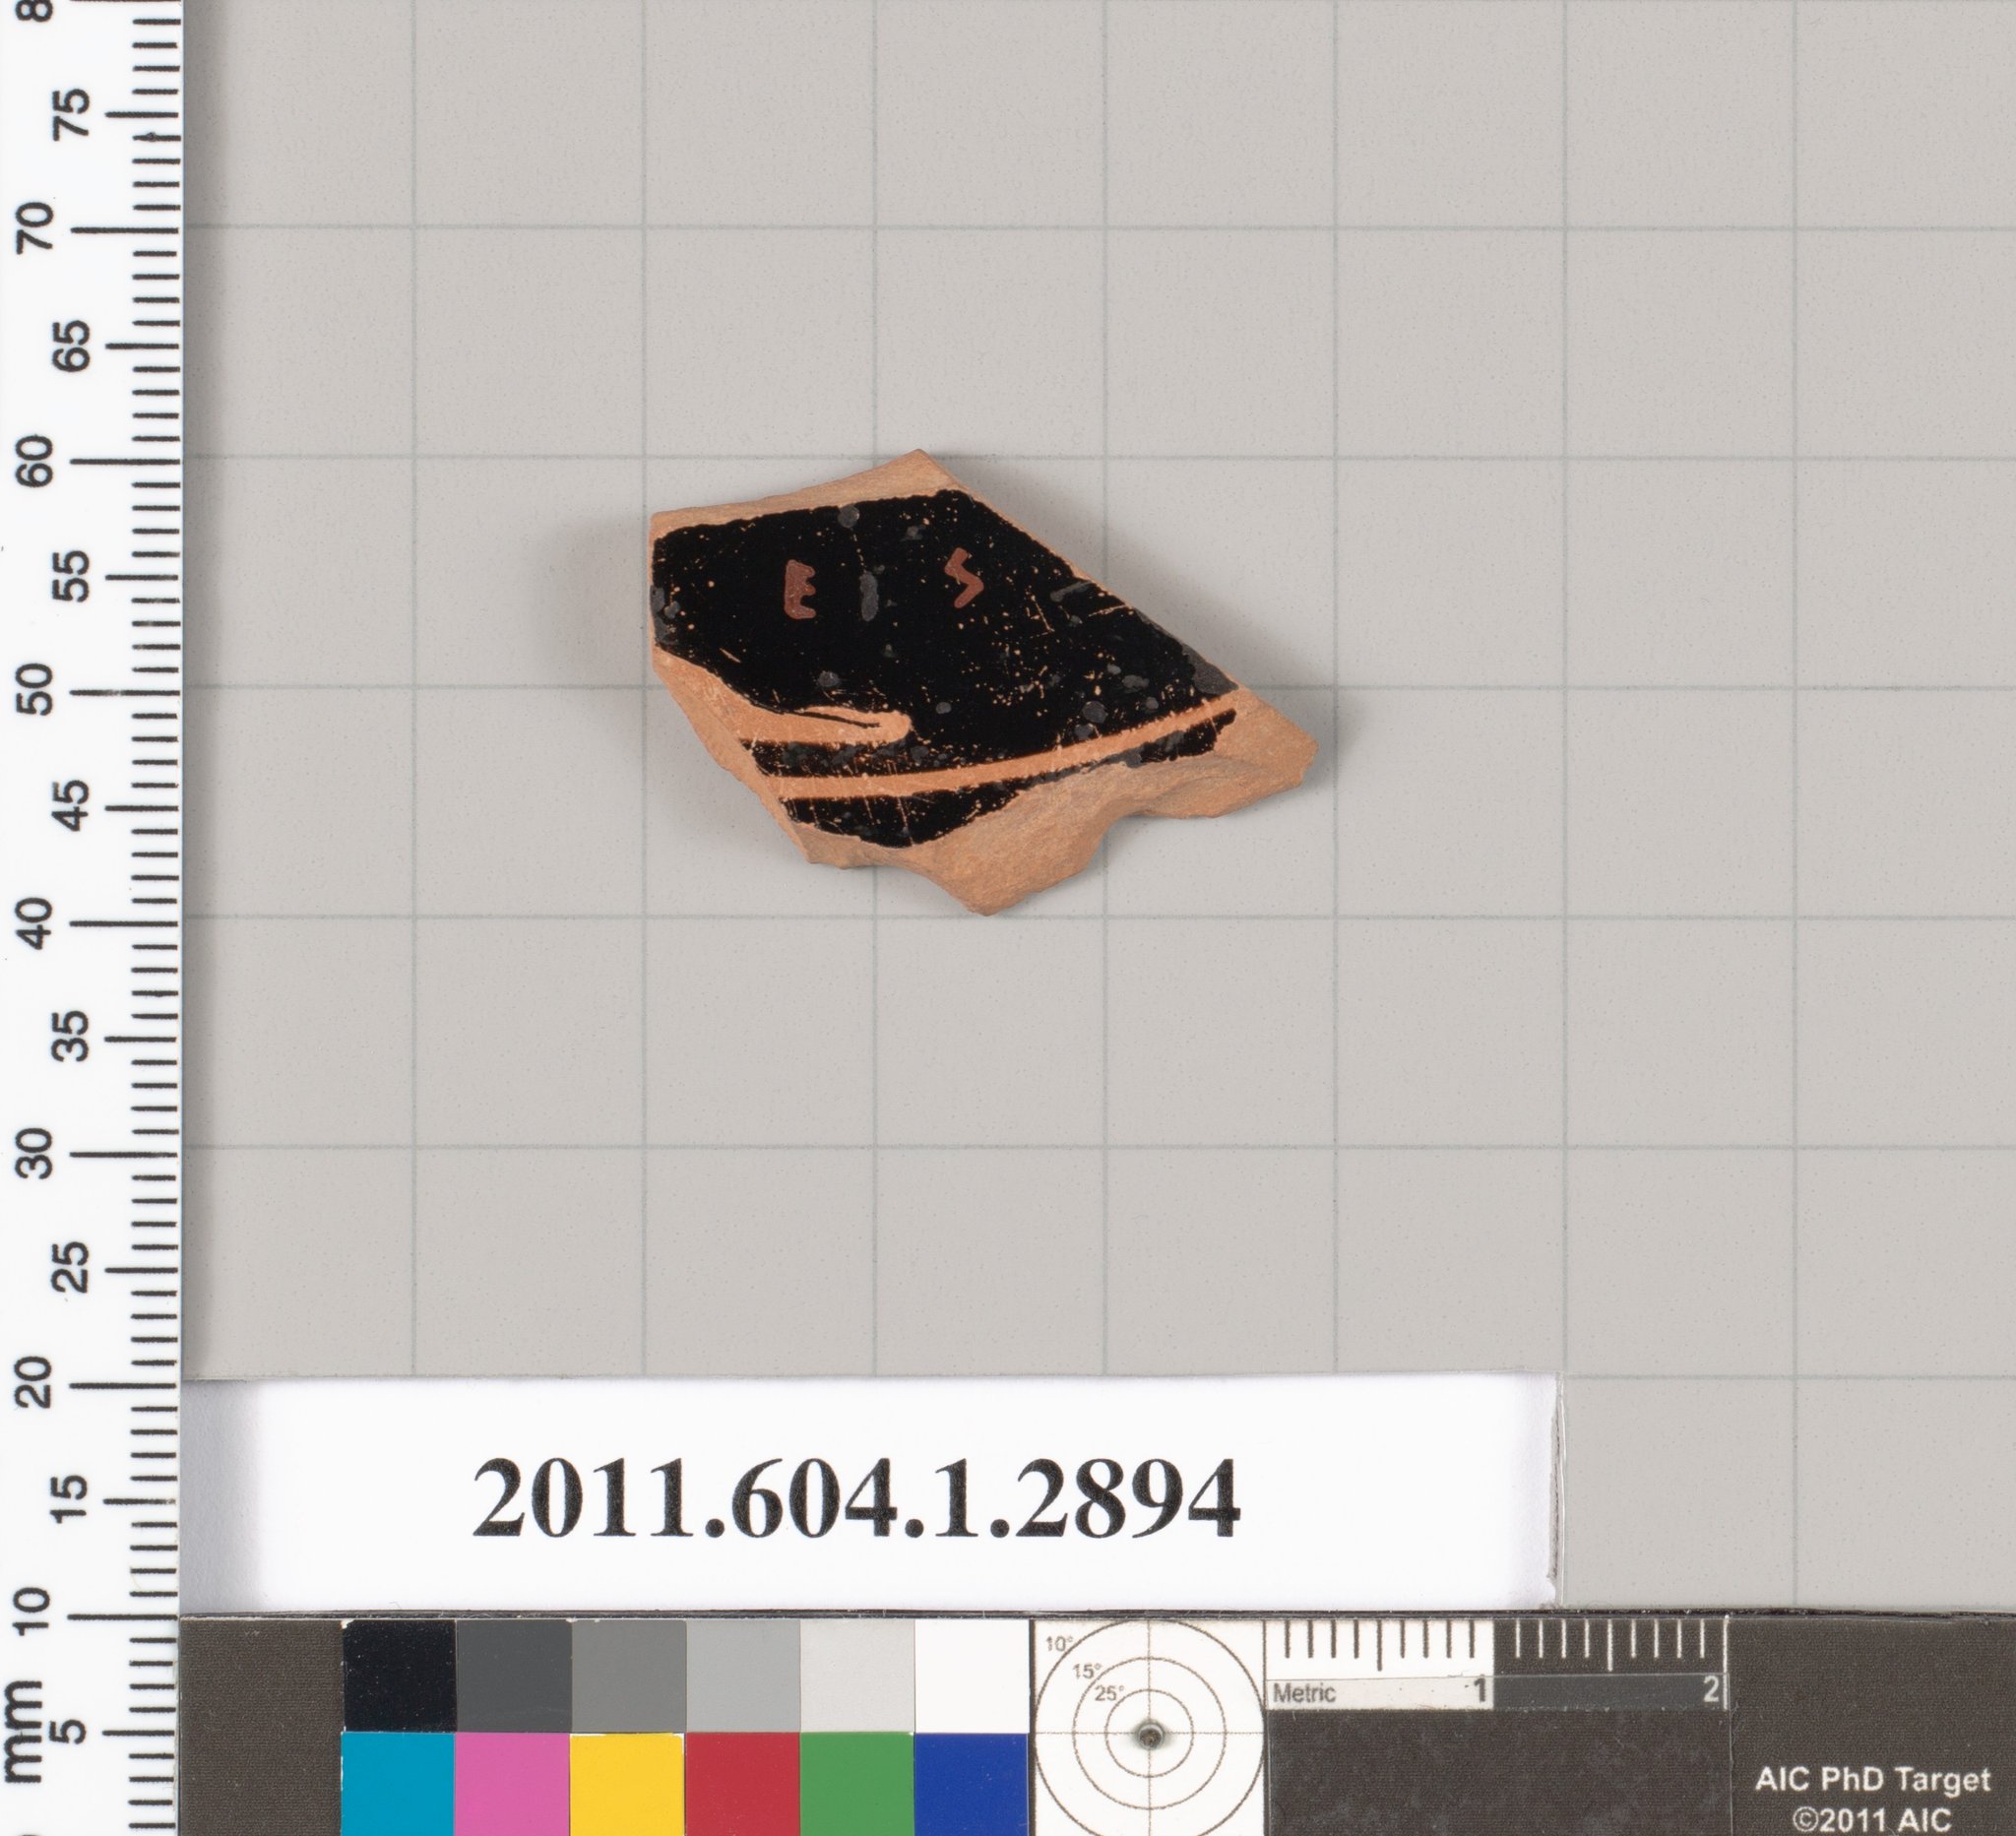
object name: kylix fragment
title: Terracotta fragment of a kylix (drinking cup)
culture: greek, attic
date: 520-500 BCE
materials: terracotta